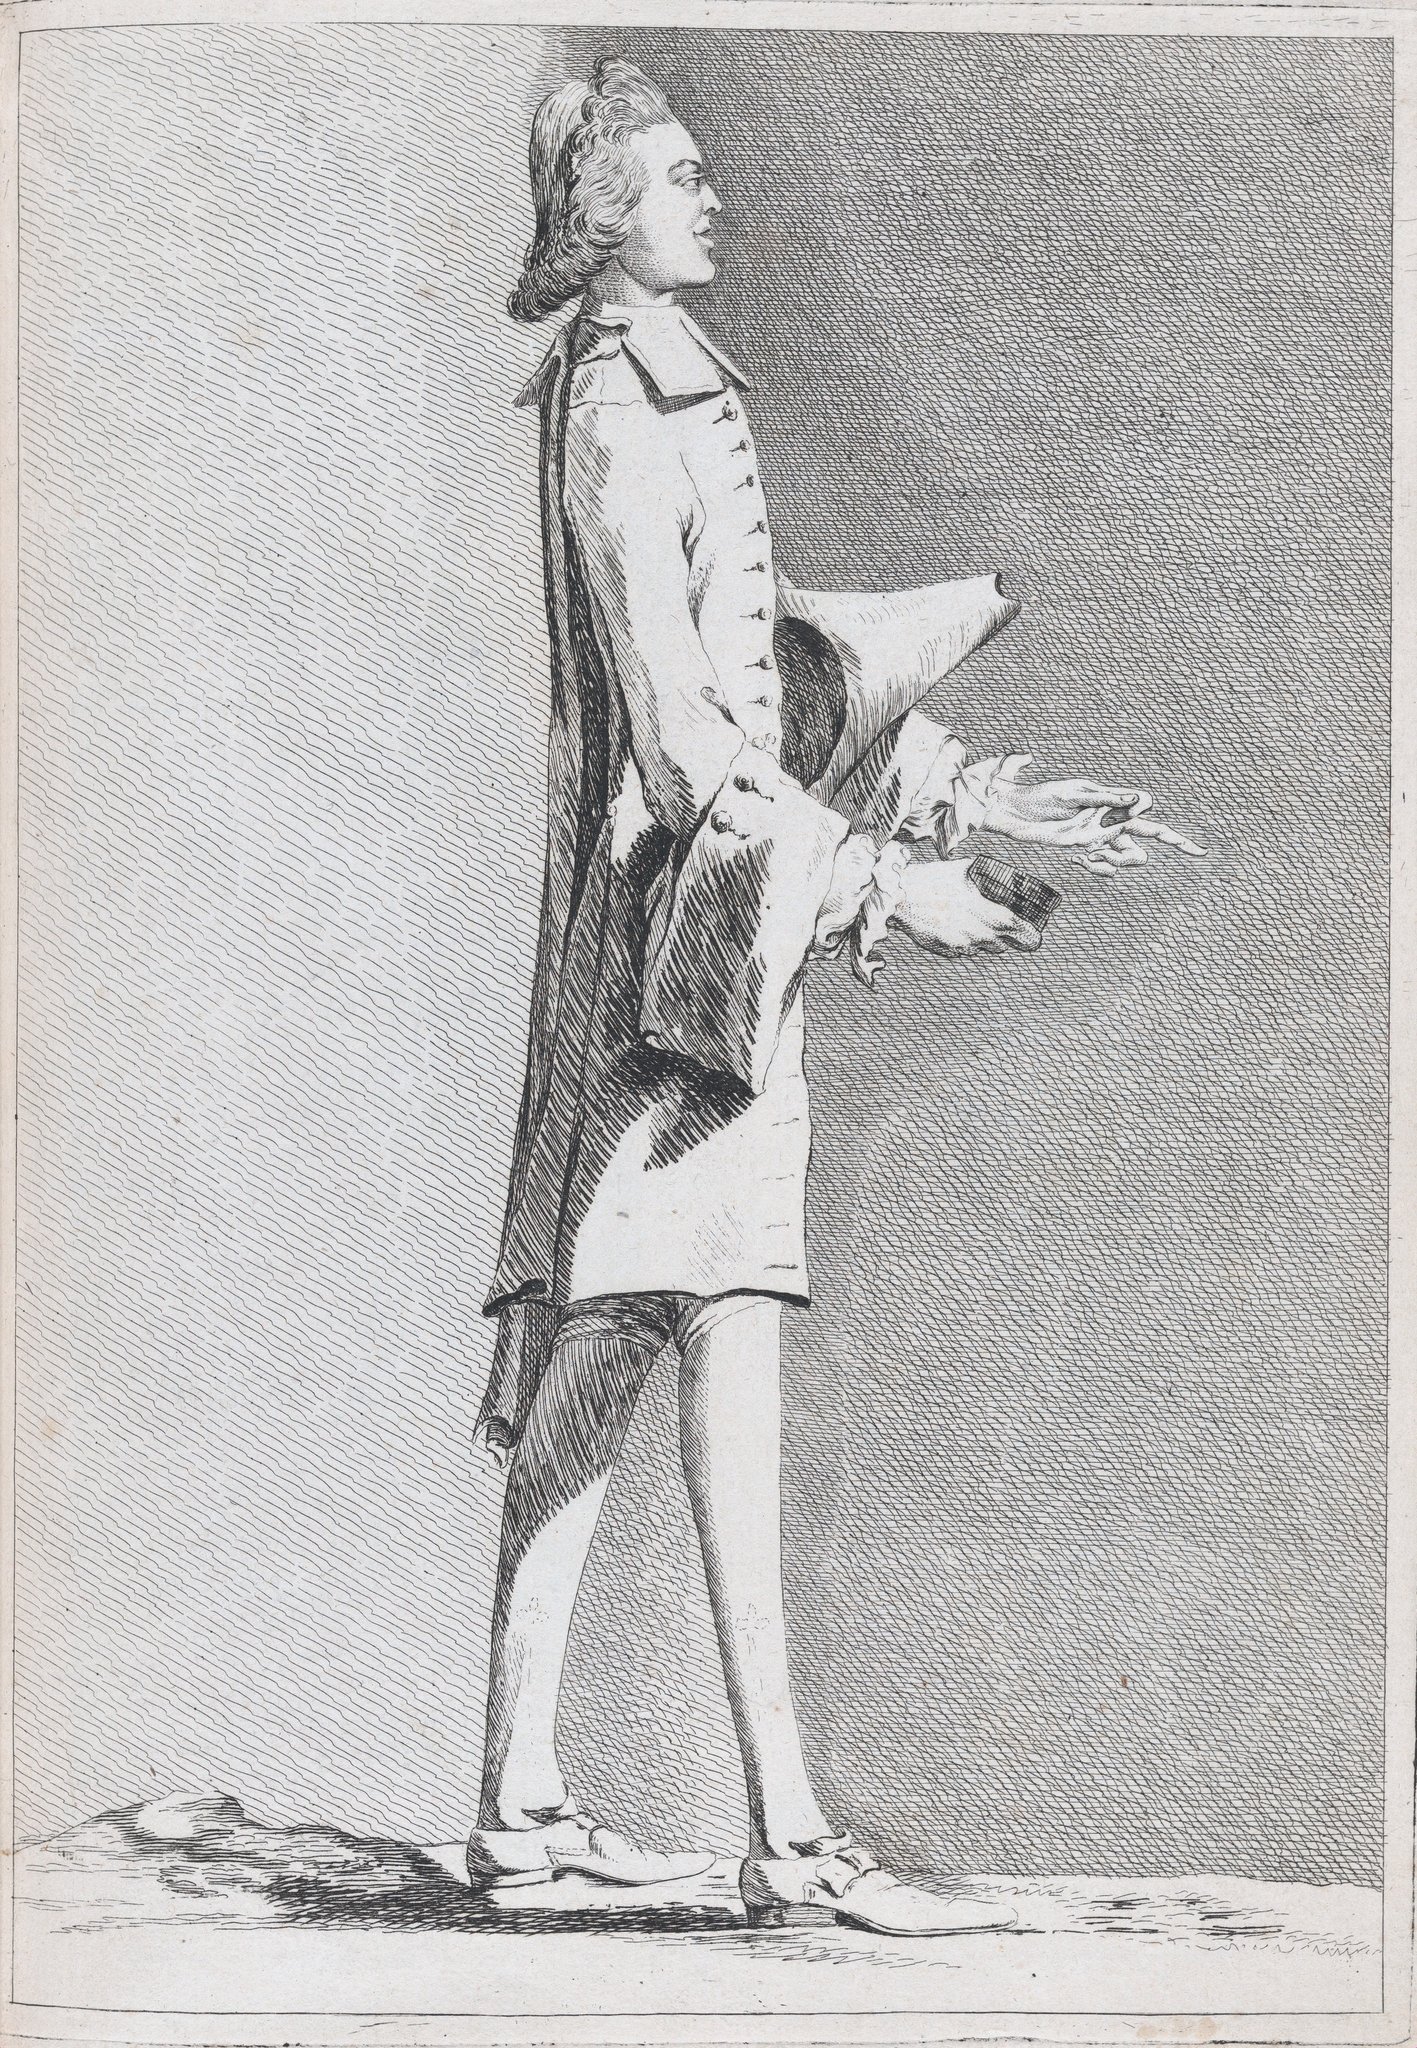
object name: print, album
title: Abbot Emeric Brulon (?), pl. XI from "Recueil de caricatures"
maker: ange-laurent de la live de jully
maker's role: artist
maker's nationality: french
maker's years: 1725-1779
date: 1754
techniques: etching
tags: men,caricature